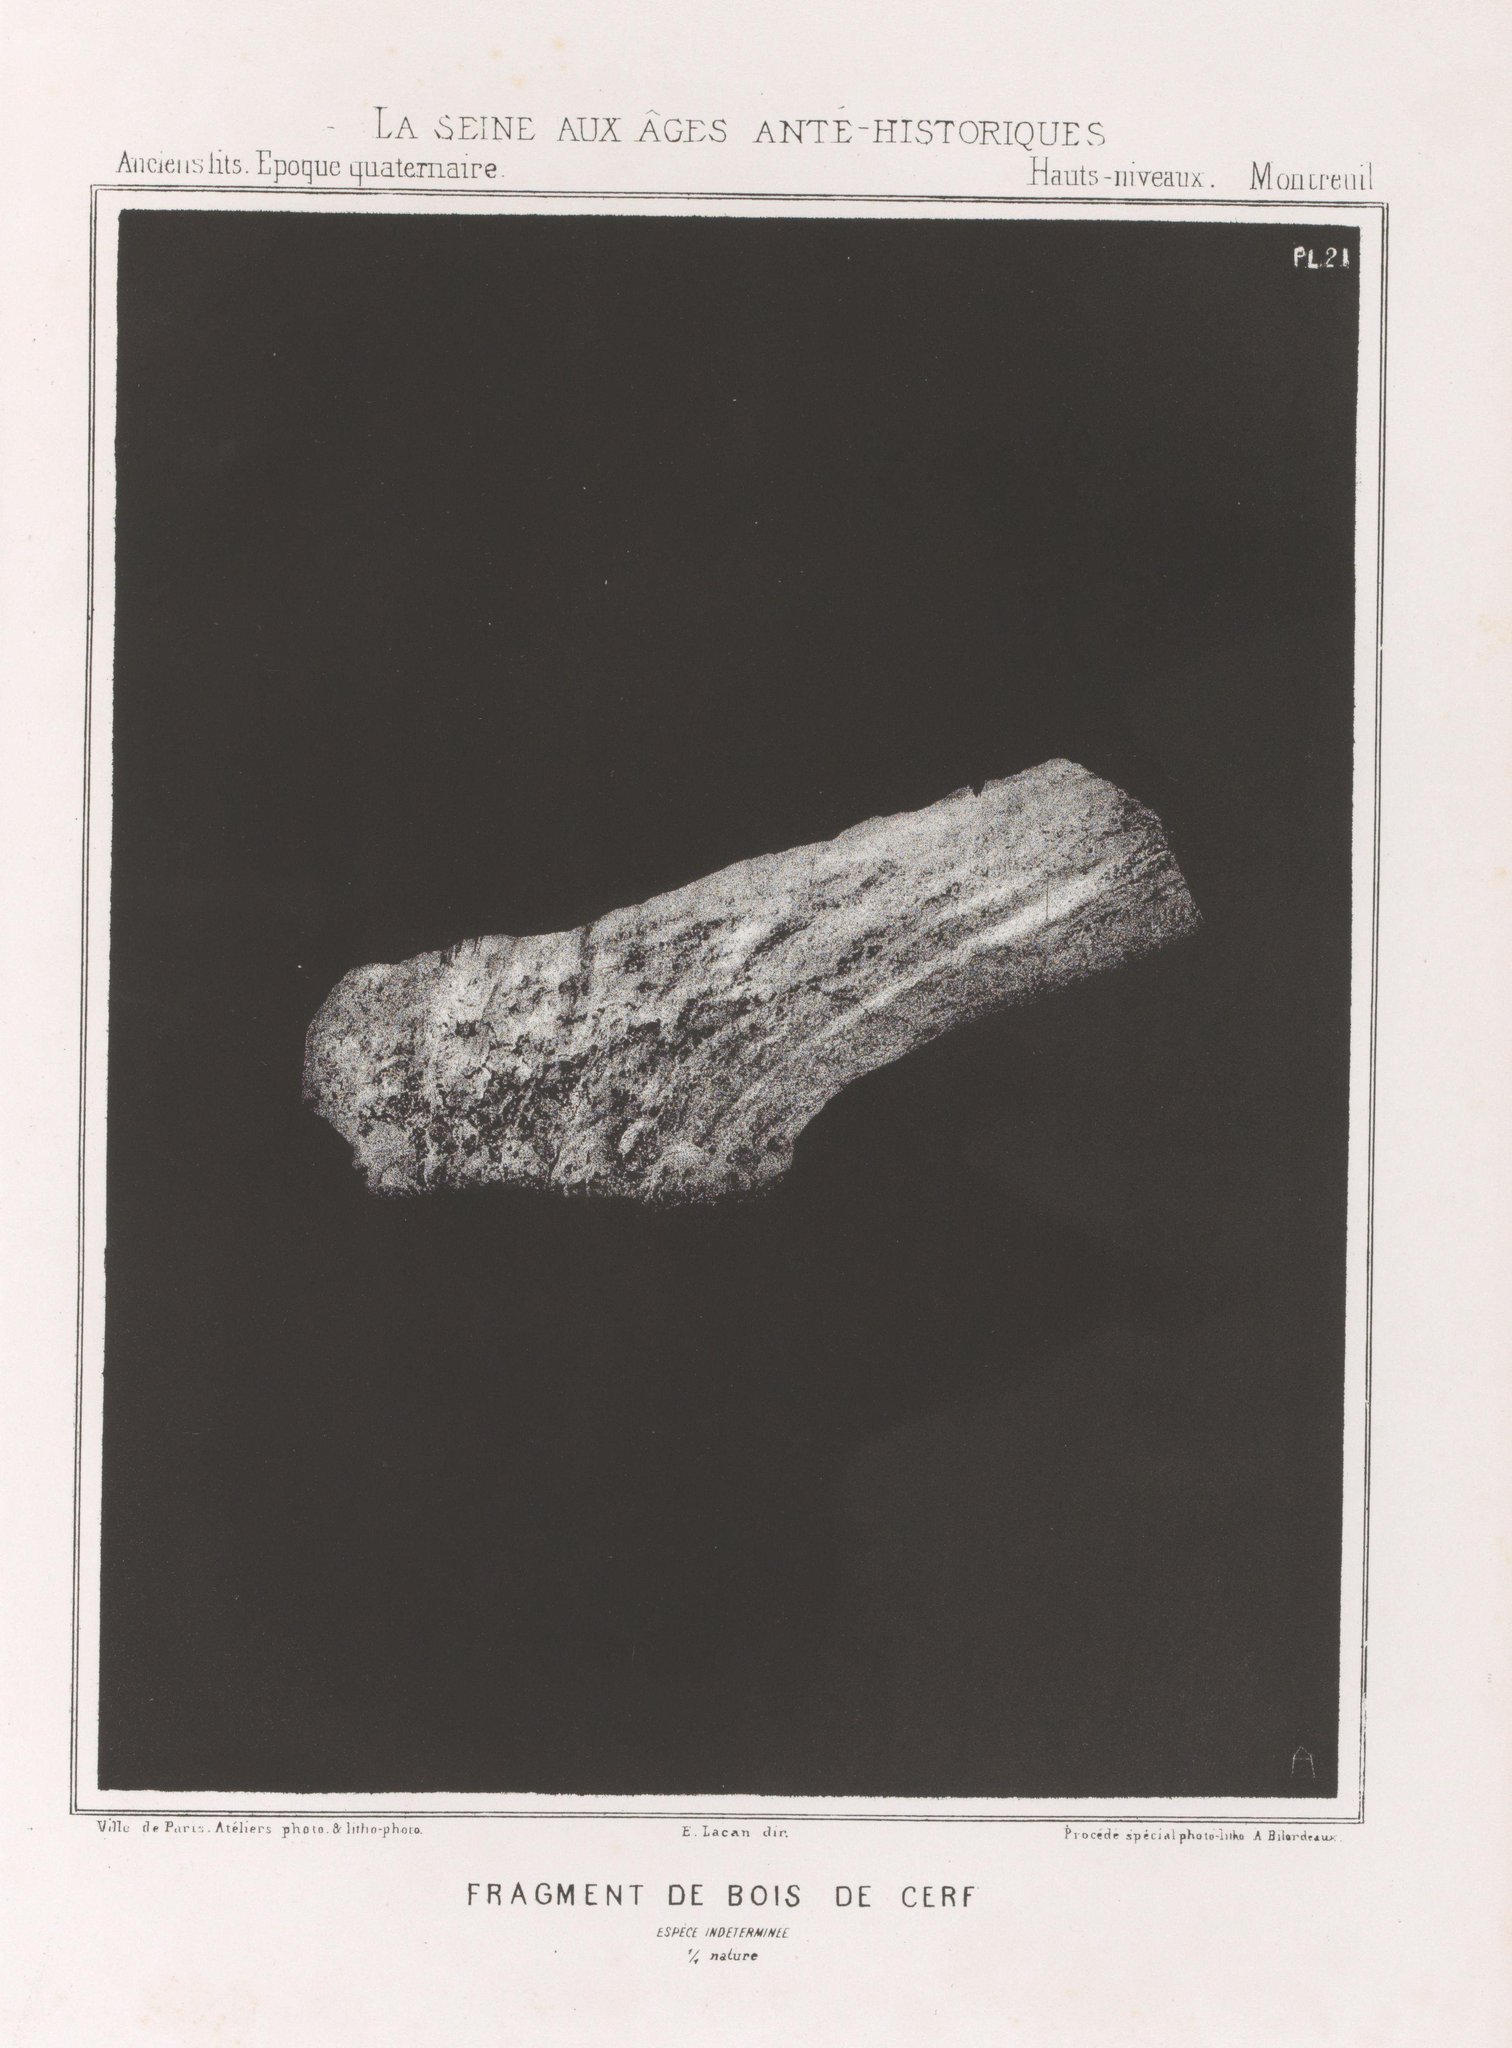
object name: page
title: Fragment van een ongedetermineerd bot van een hert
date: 1860-1869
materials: paper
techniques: photolithography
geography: france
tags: animals (+ skeleton of an animal), palaeontology, france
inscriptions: number: ‘Pl. 21’, inscription: ‘Ville de Paris Ateliers photo & litho-photo. E. Lacan, dir. Procédé spécial photo-litho A. Bilordeaux’, monogram: ‘AB’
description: Voor plek prent in boek: zie nummer onder 'Opschriften / Merken'.